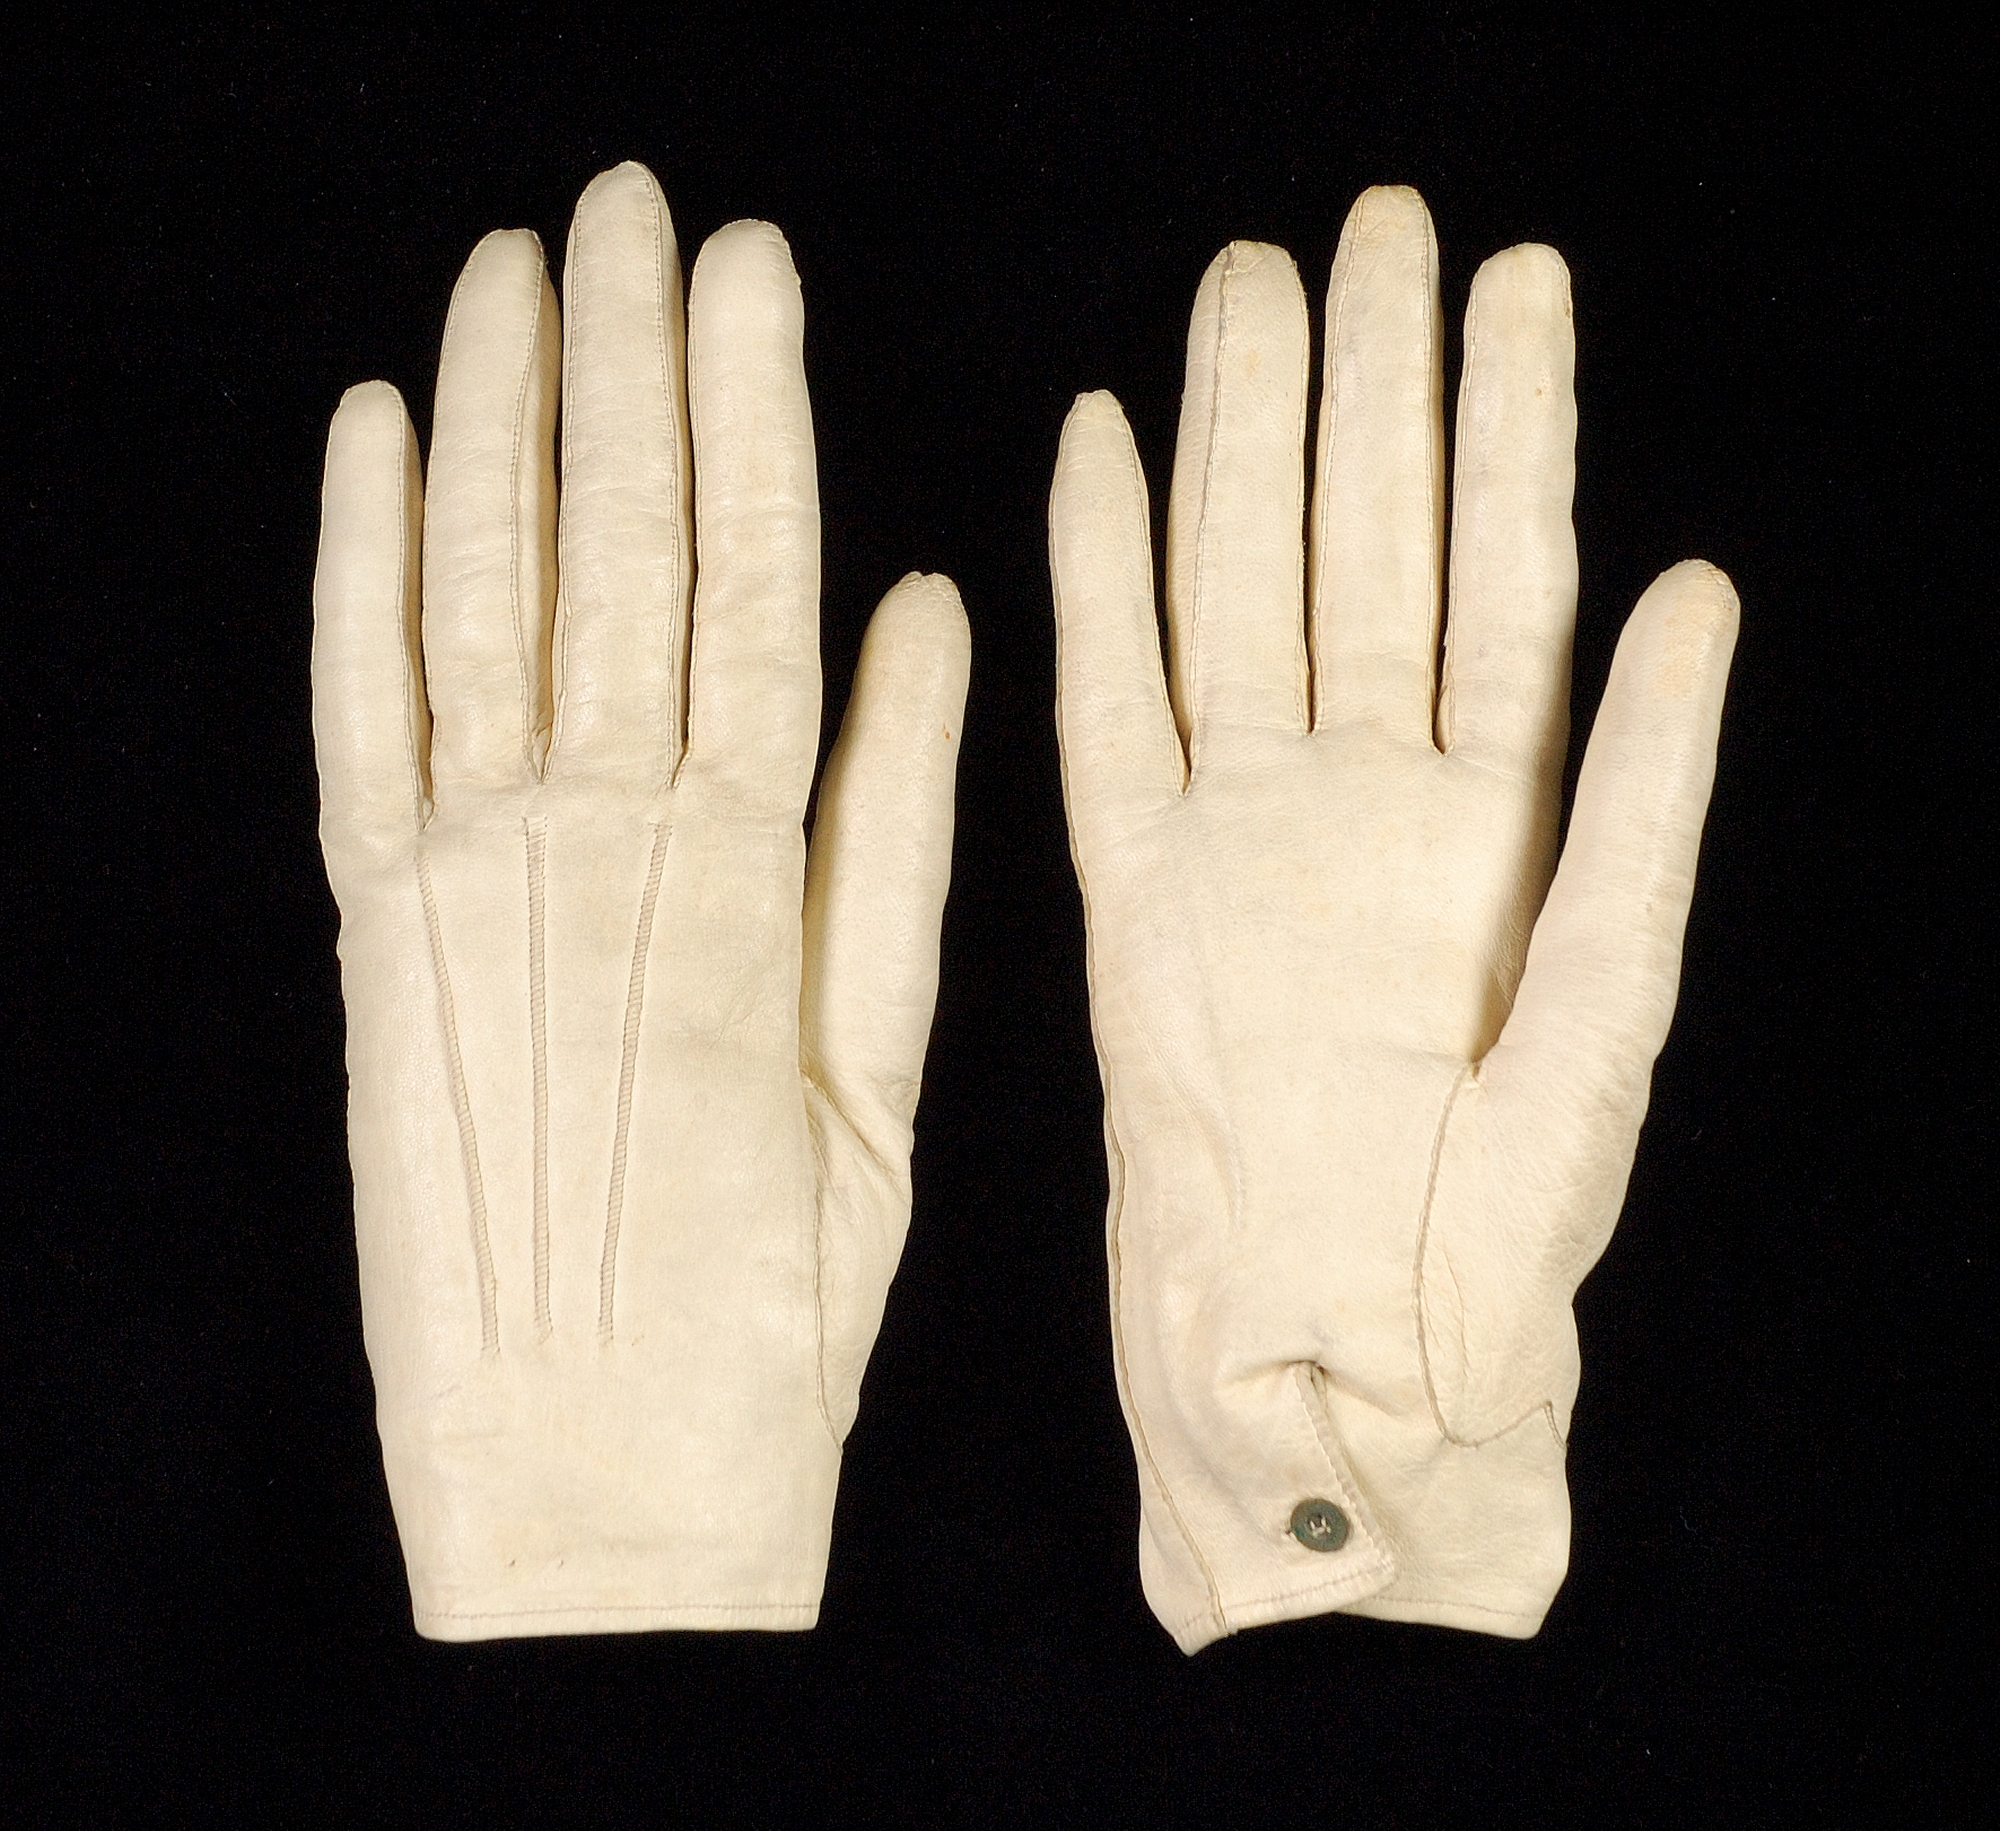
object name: evening glove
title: Evening gloves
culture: french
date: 1848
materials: leather